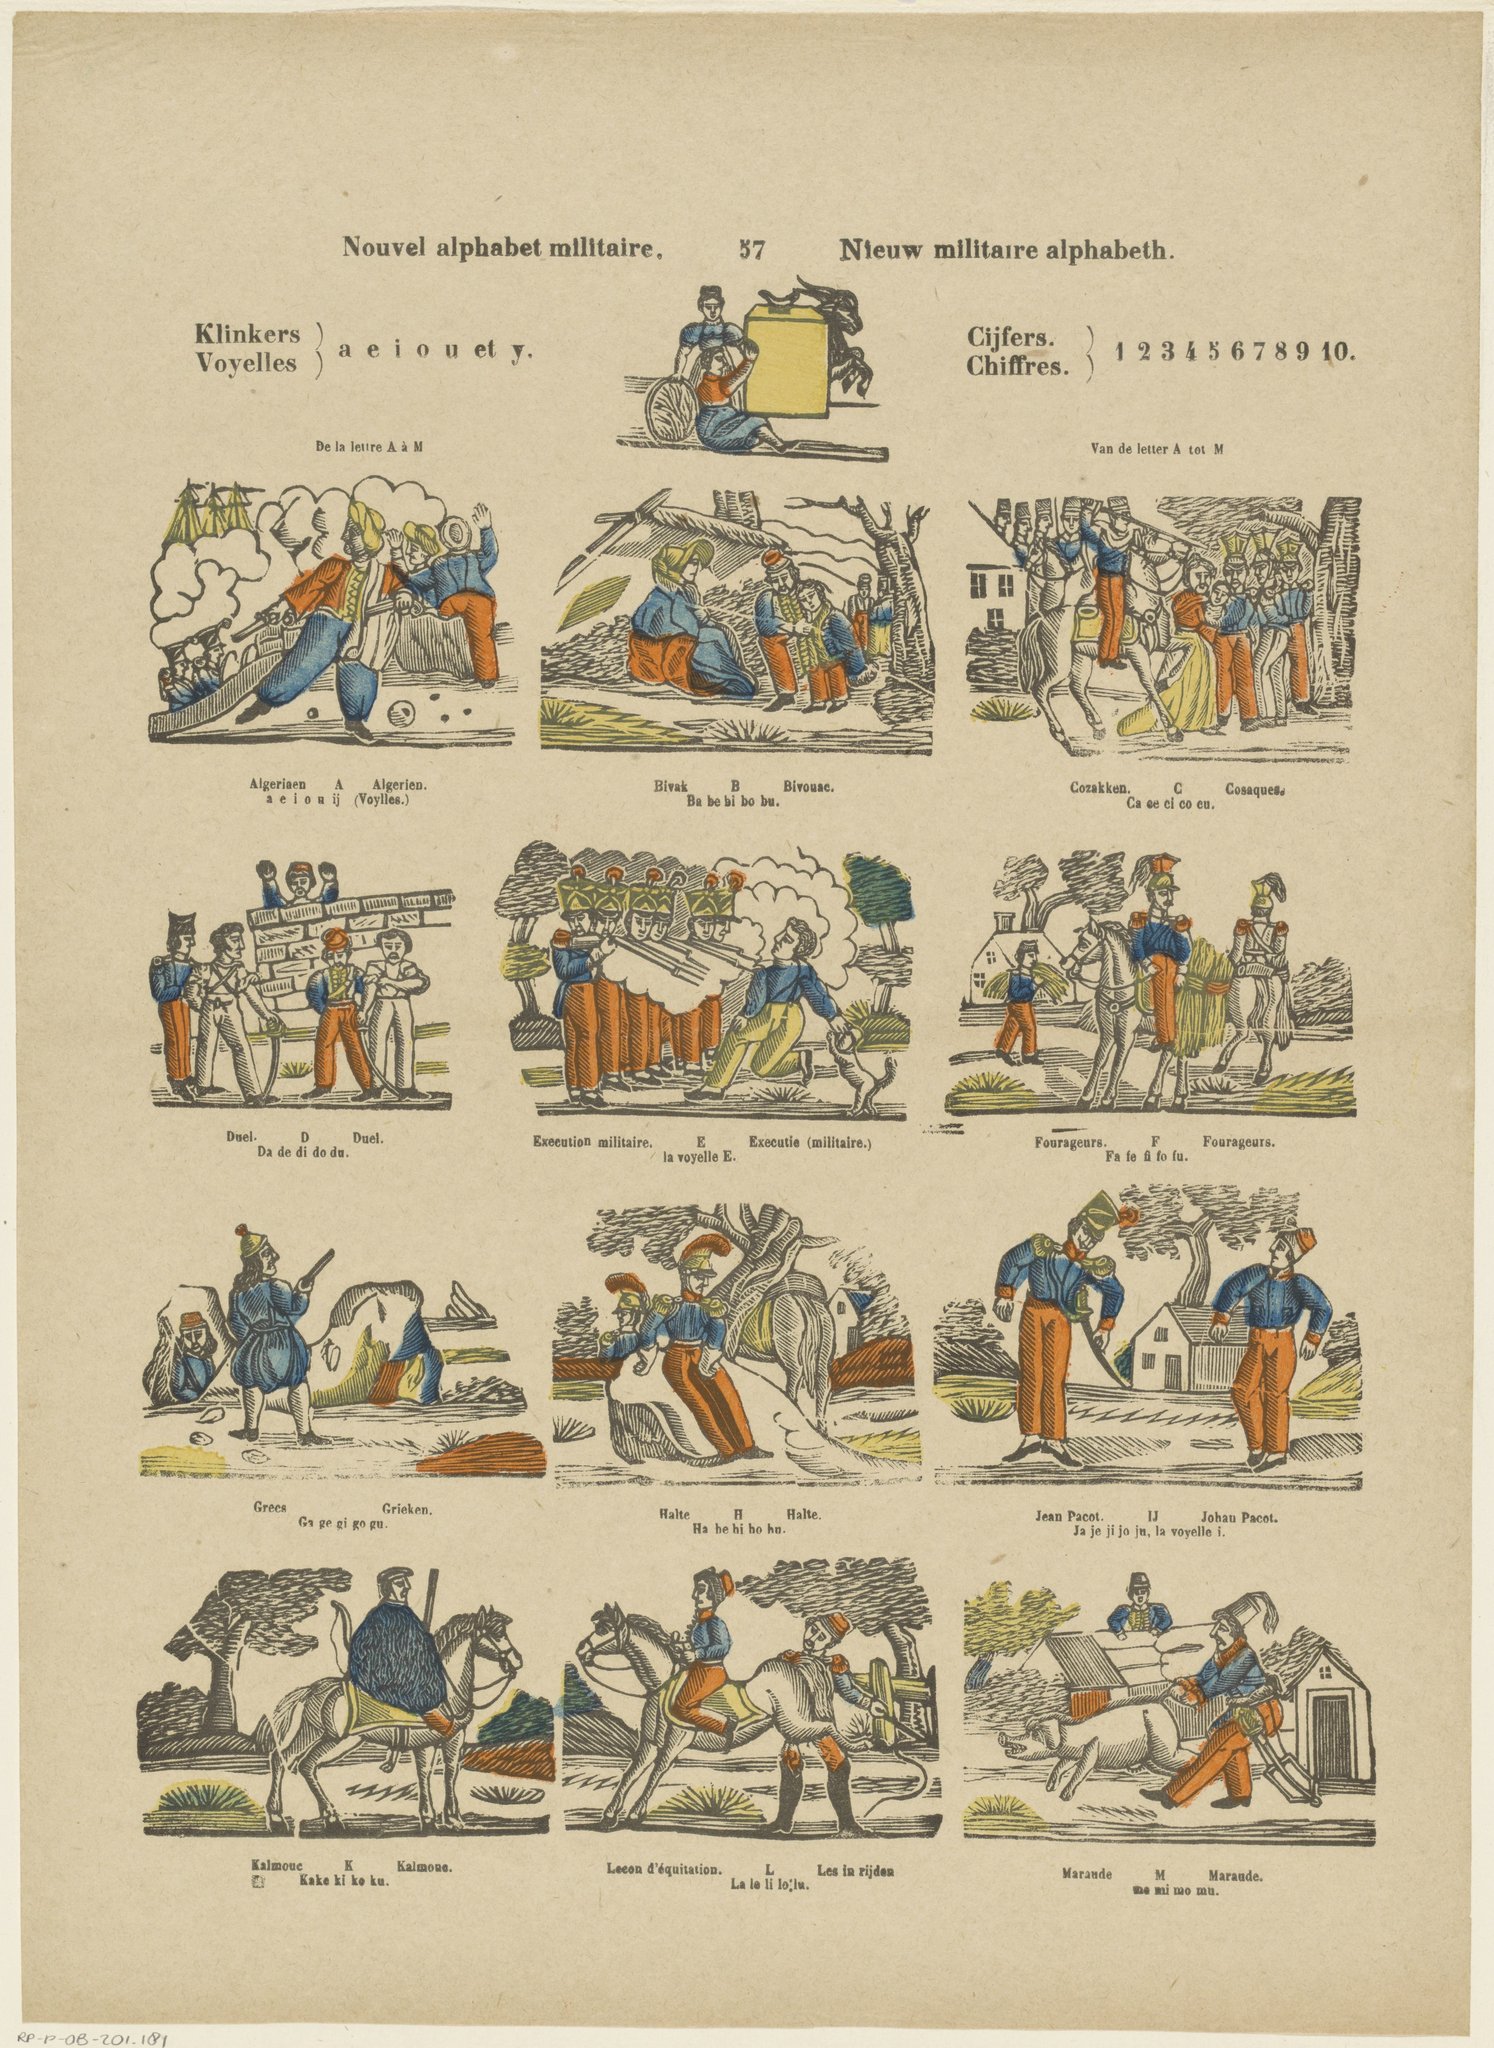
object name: popular print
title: Nouvel alphabet militaire / Nieuw militaire alphabeth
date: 1866-1902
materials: paper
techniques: colour, letterpress printing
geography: europe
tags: letters, alphabet, script, the soldier; the soldier's life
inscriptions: collector's mark: Lugt 2760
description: Blad met 13 voorstellingen van de letters van het alfabet (A-M)geïllustreerd met militairen waarvan de woorden met de betreffende letter beginnen. Onder elke voorstelling een onderschrift in het Nederlands en in het Frans. Genummerd midden boven: 57.